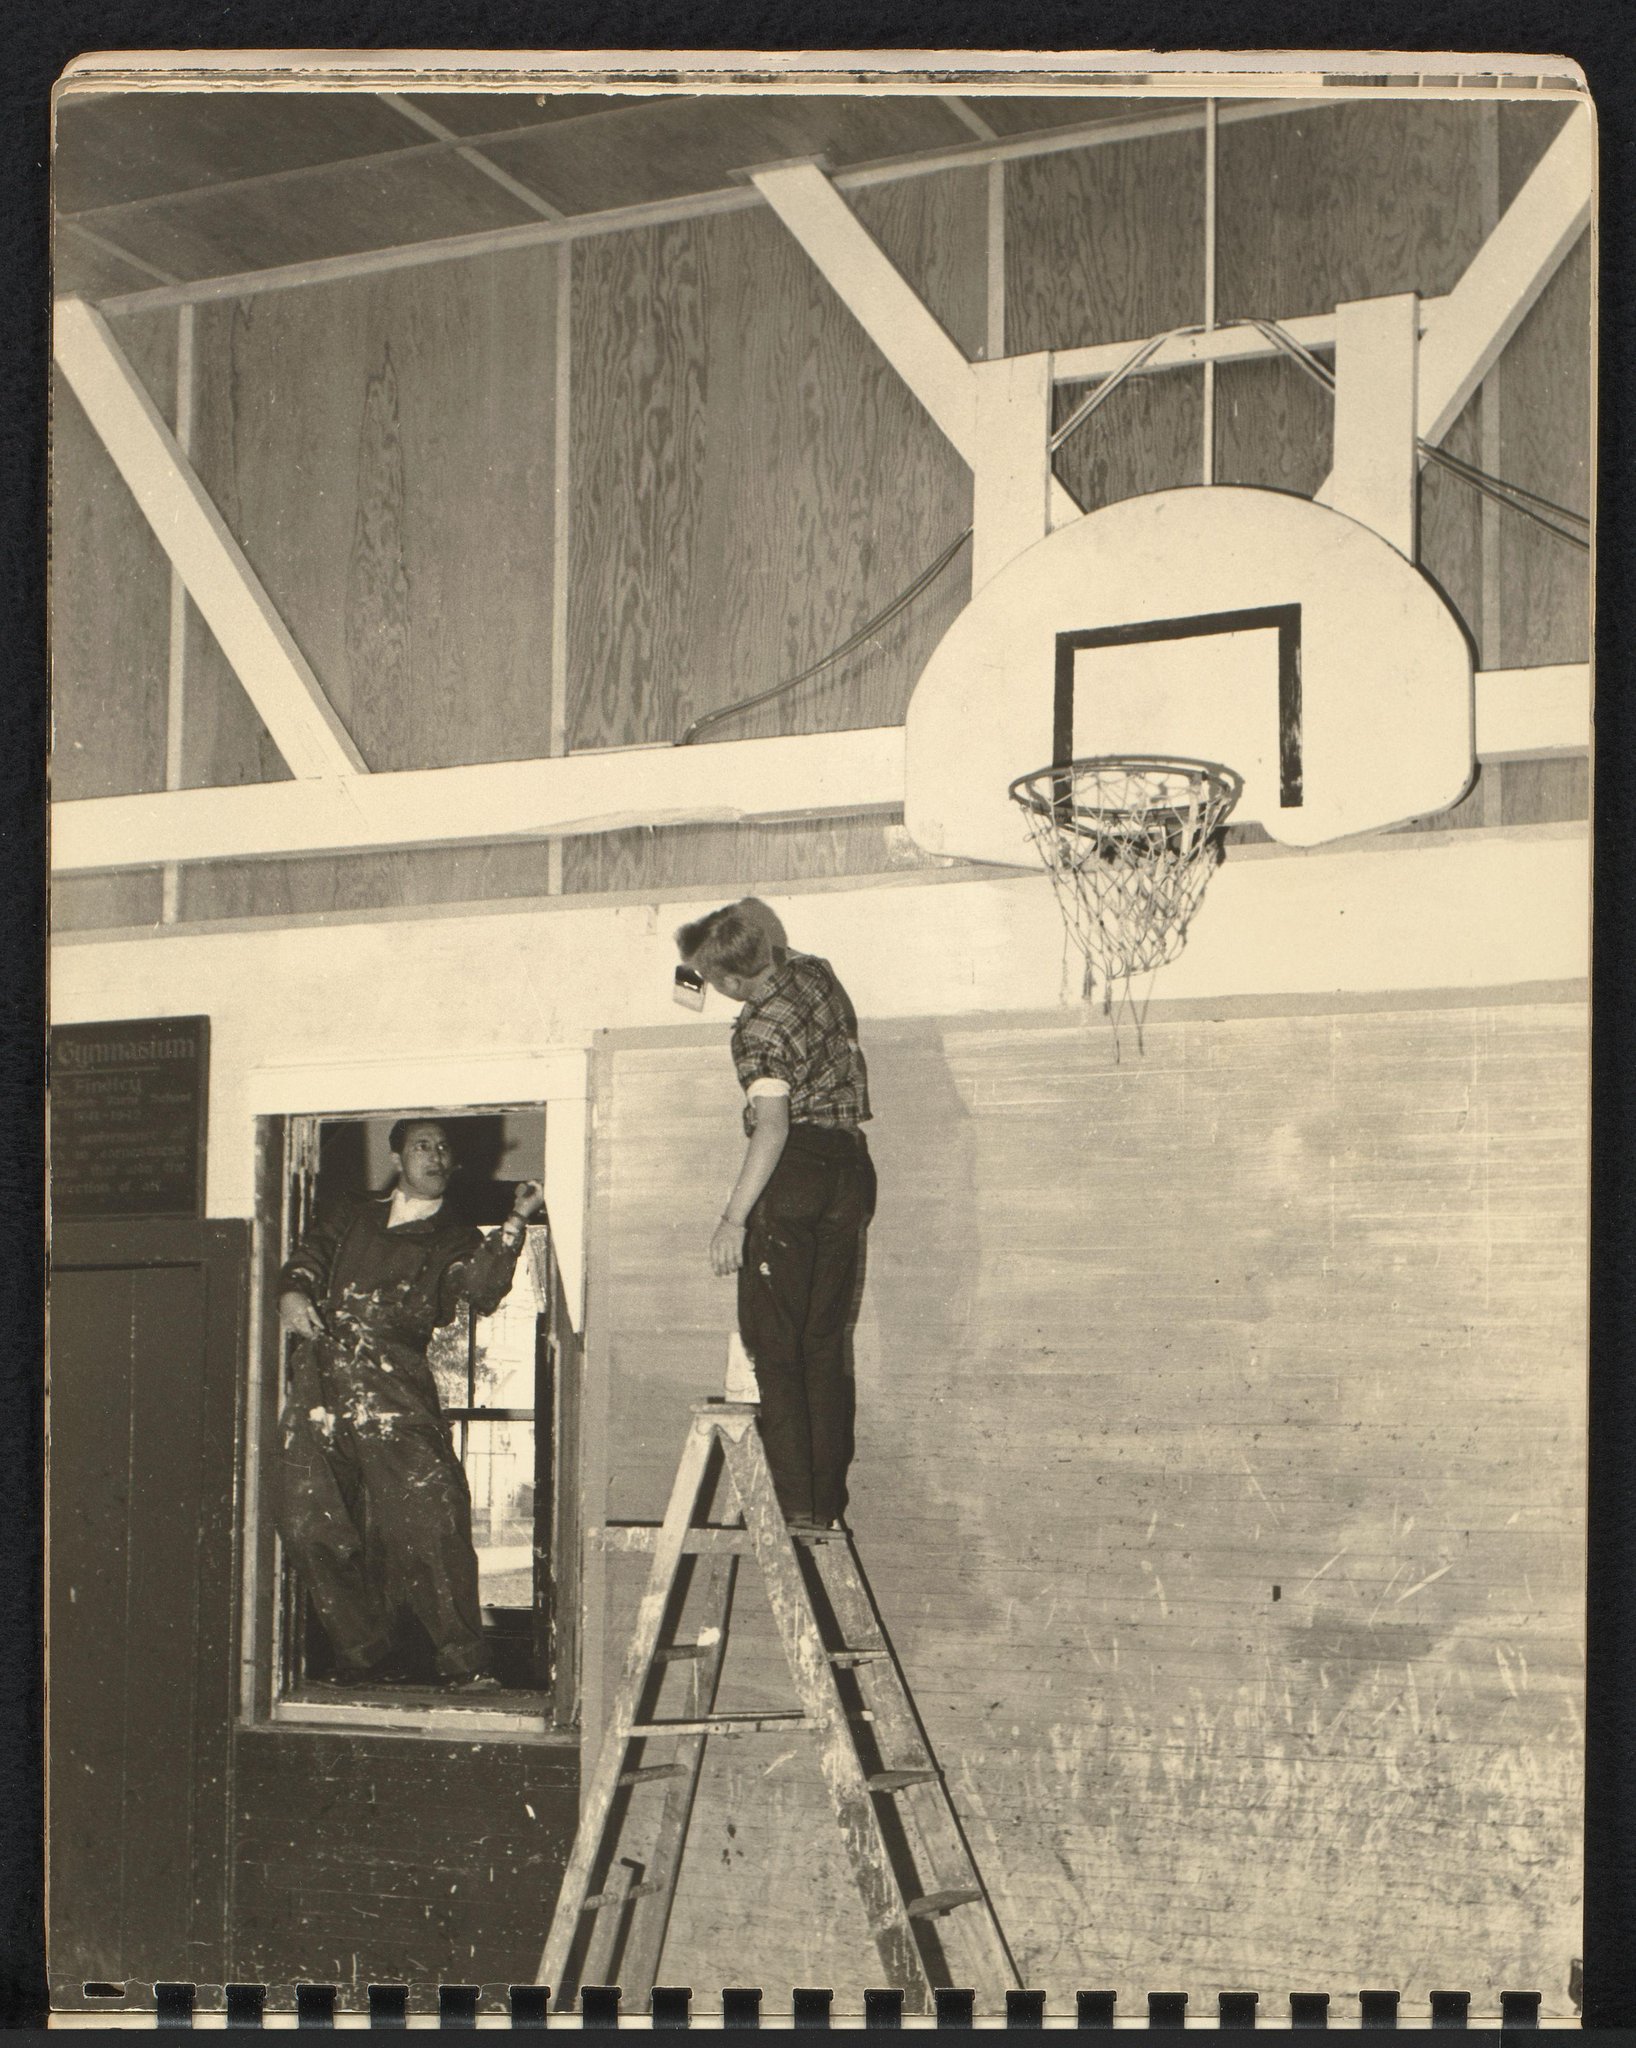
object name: photograph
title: Werkzaamheden in het gymnastiekgebouw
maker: Anonymous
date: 1950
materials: paper, photographic support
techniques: gelatin silver print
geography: new york city